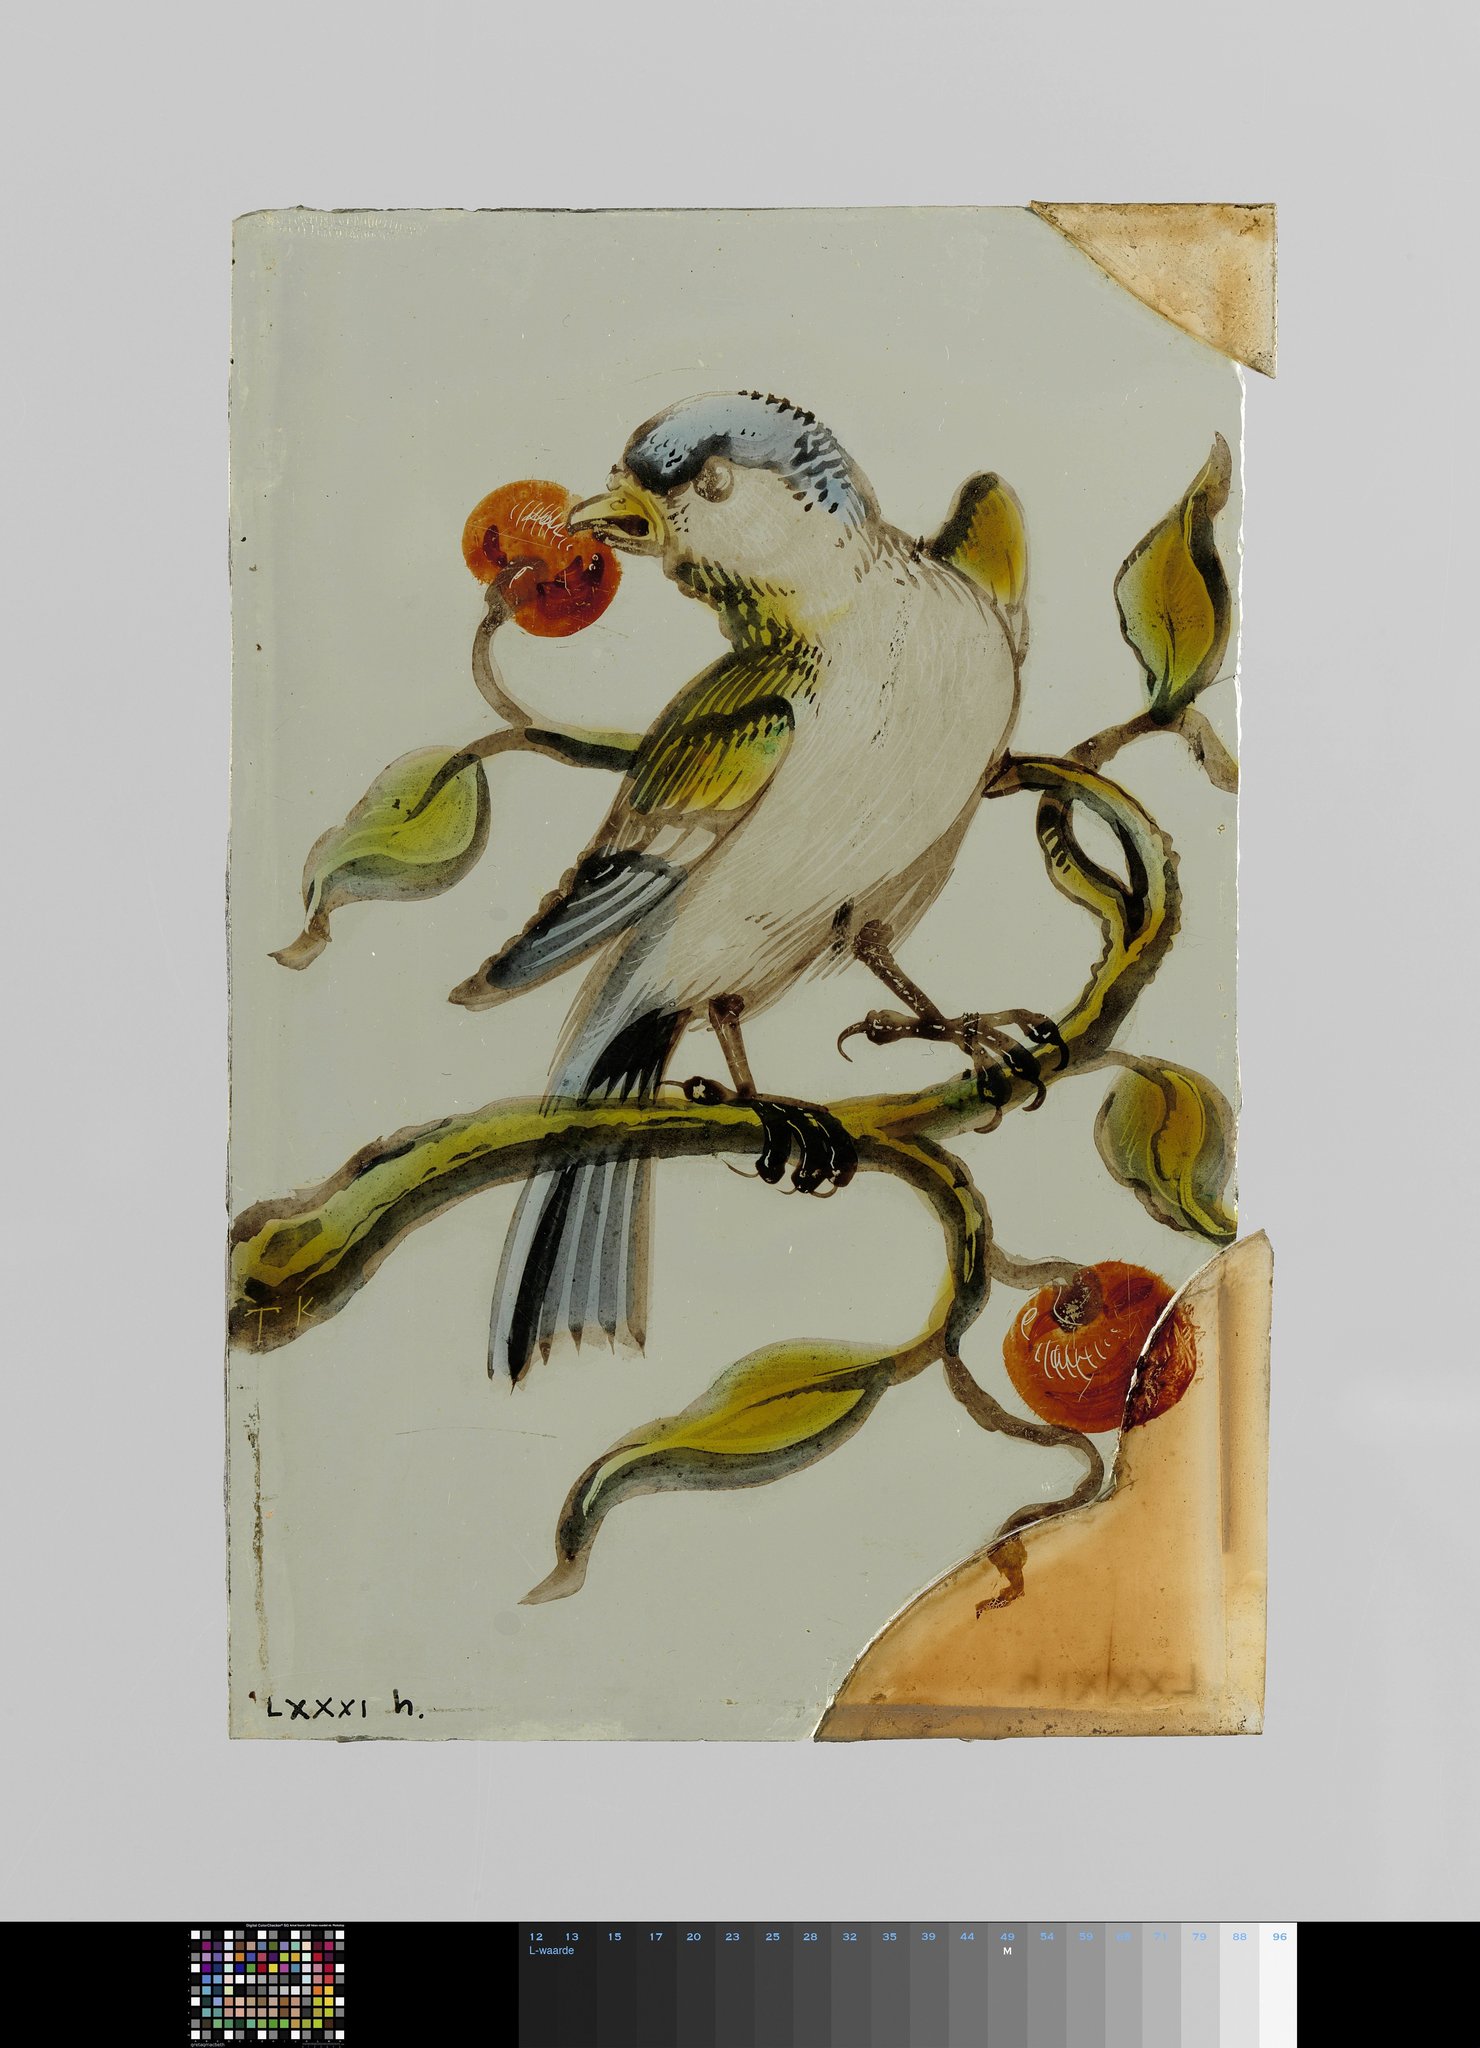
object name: light window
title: Ruit met een vogel op een tak met kersen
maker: Anonymous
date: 1650-1675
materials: glass, lead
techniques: enamel painting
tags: birds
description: Een ruit met emailschildering van een vogel gezeten op een tak met kersen in overwegend blauw, grisaille en zilvergeel.